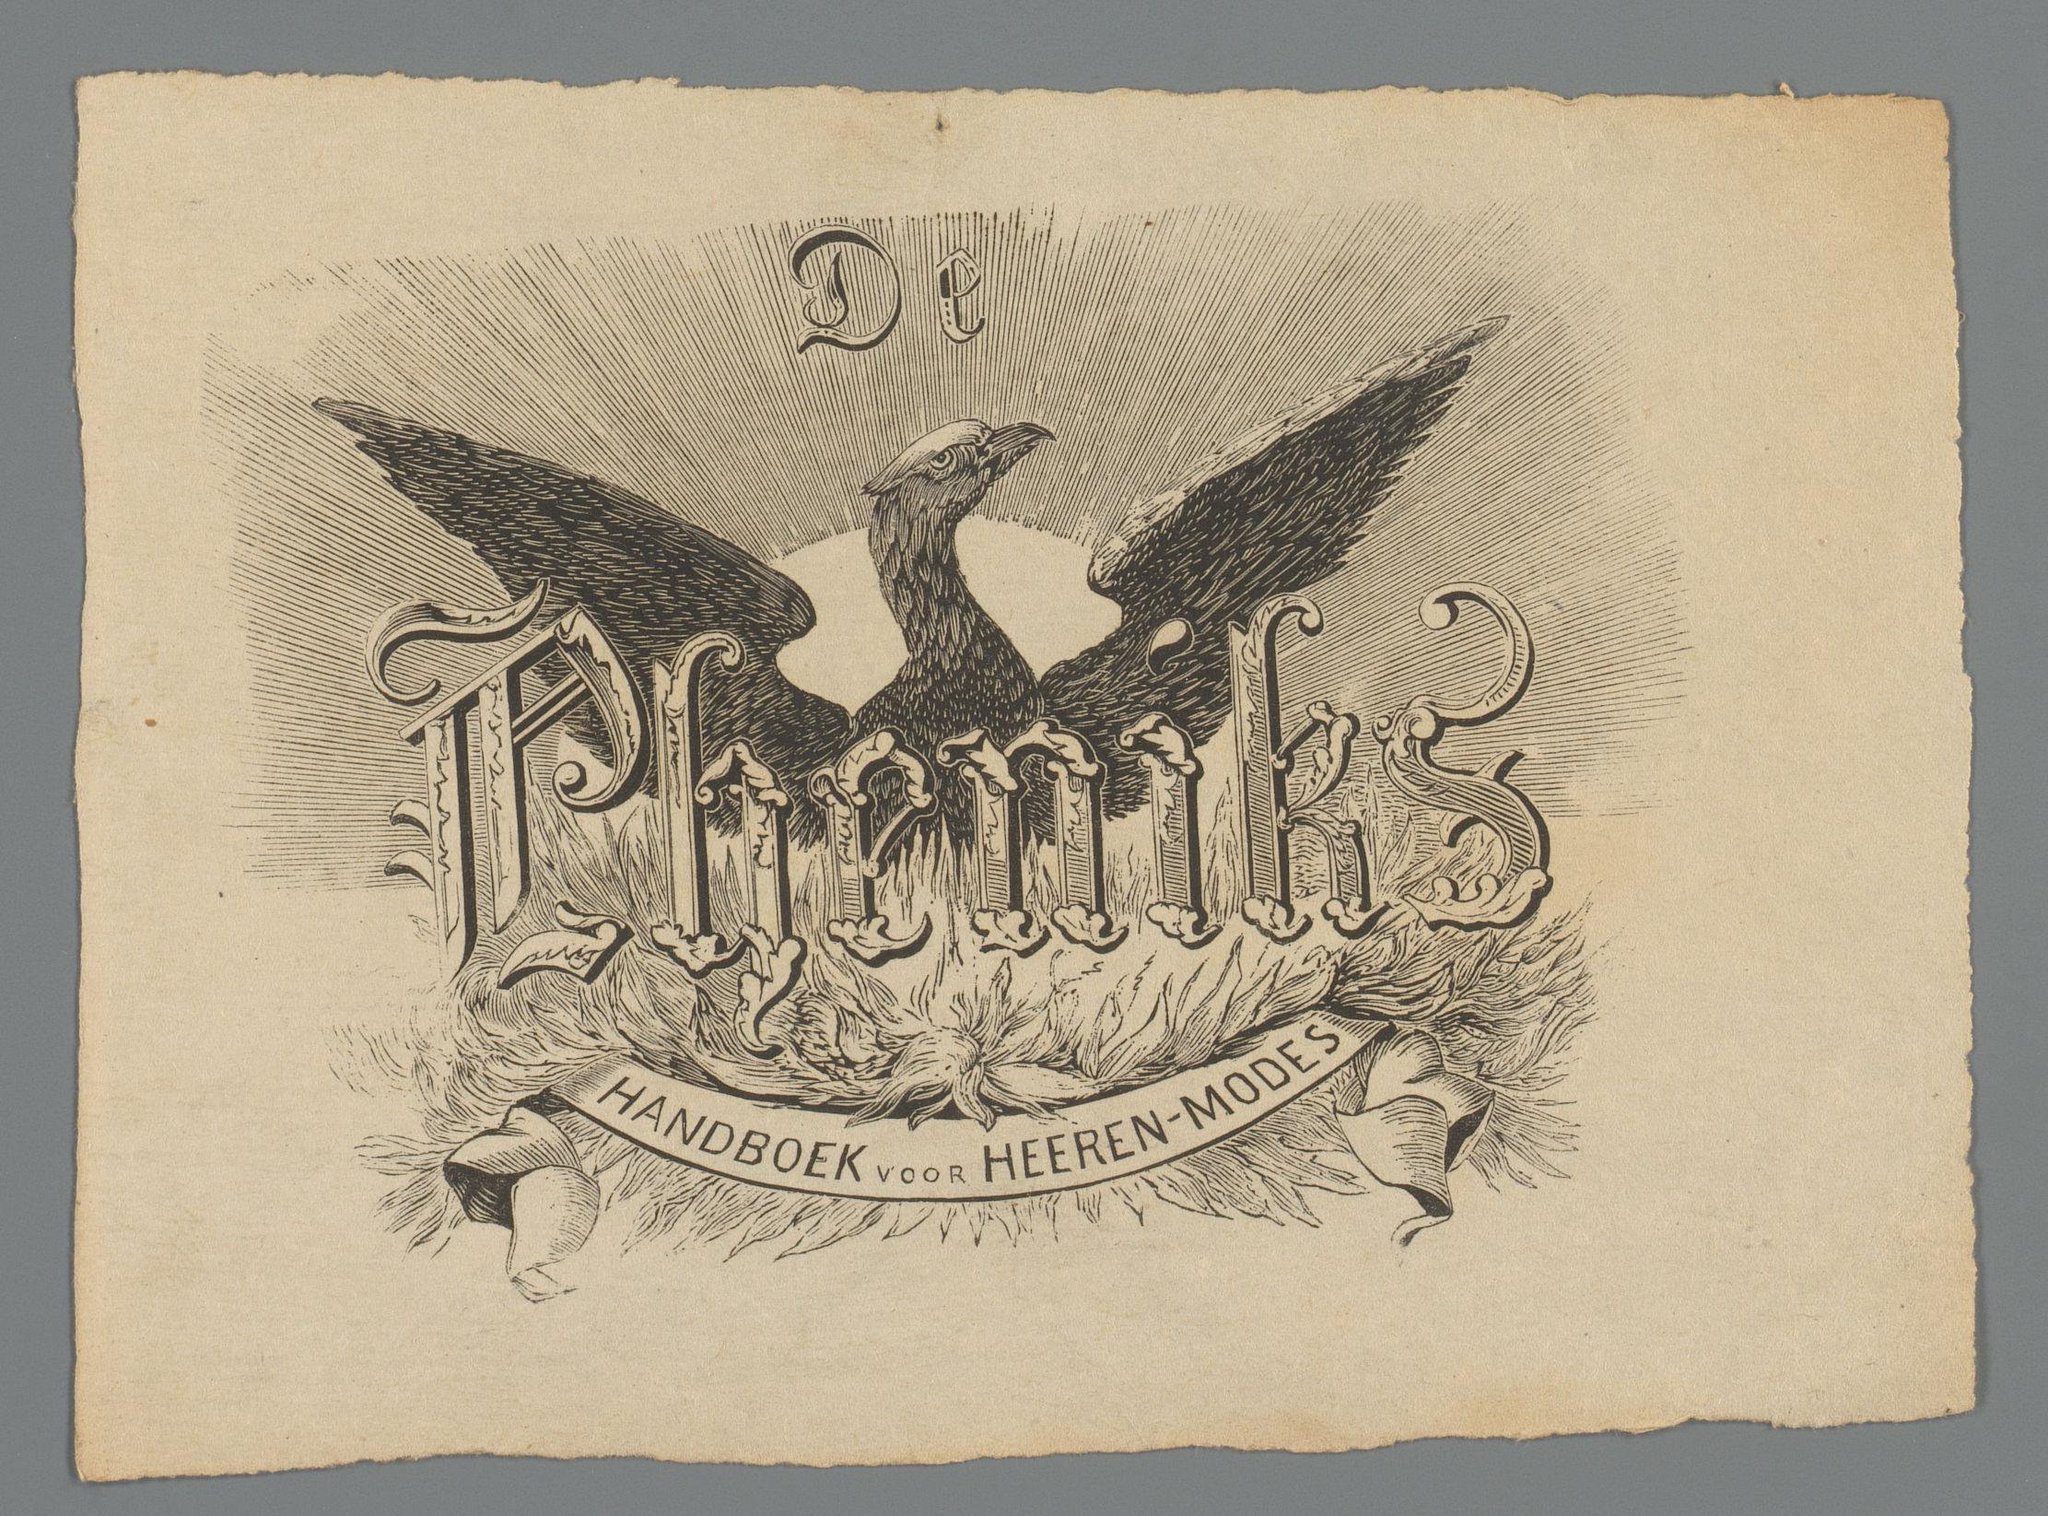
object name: print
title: Vignet met een feniks die uit vlammen oprijst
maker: Anonymous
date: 1856-1860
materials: paper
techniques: engraving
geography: amsterdam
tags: fabulous animals ~ birds: phoenix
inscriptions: annotation: ‘Weissenbruch’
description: Vignet uit: De pheniks. Handboek voor heeren-modes. Amsterdam: Gebr. Van Es, 1856.